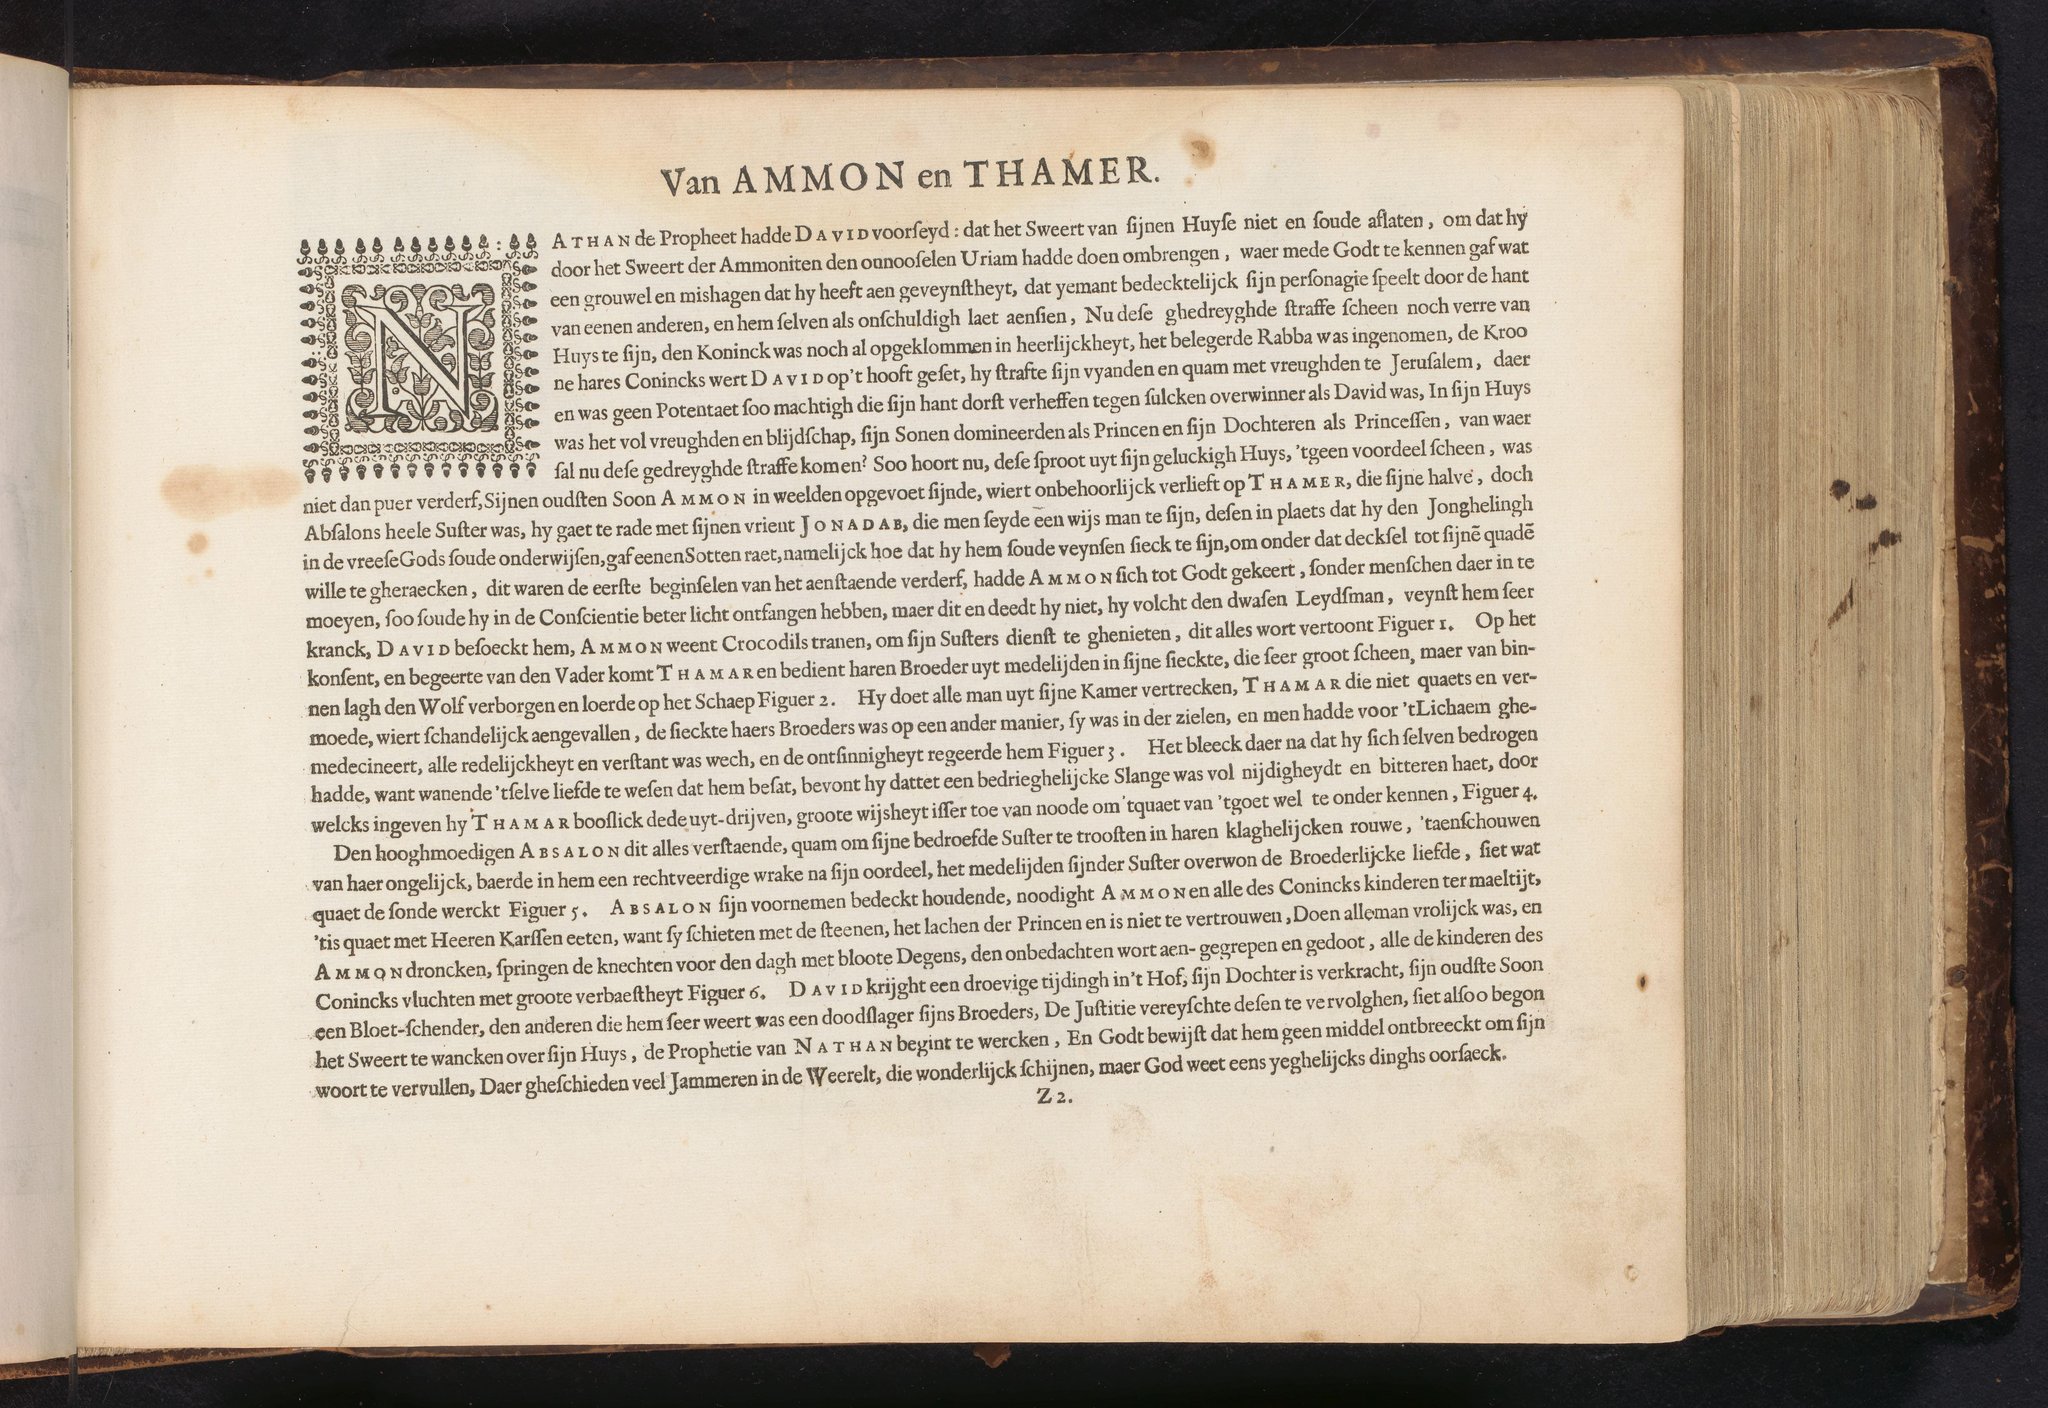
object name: album leaf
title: Den Grooten Figuer-Bibel (...)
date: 1646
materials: paper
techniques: letterpress printing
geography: alkmaar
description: Tekstblad bij een serie prenten over de geschiedenis van Tamar en Amnon. Linksboven initiaal N. Dit blad maakt deel uit van een album.